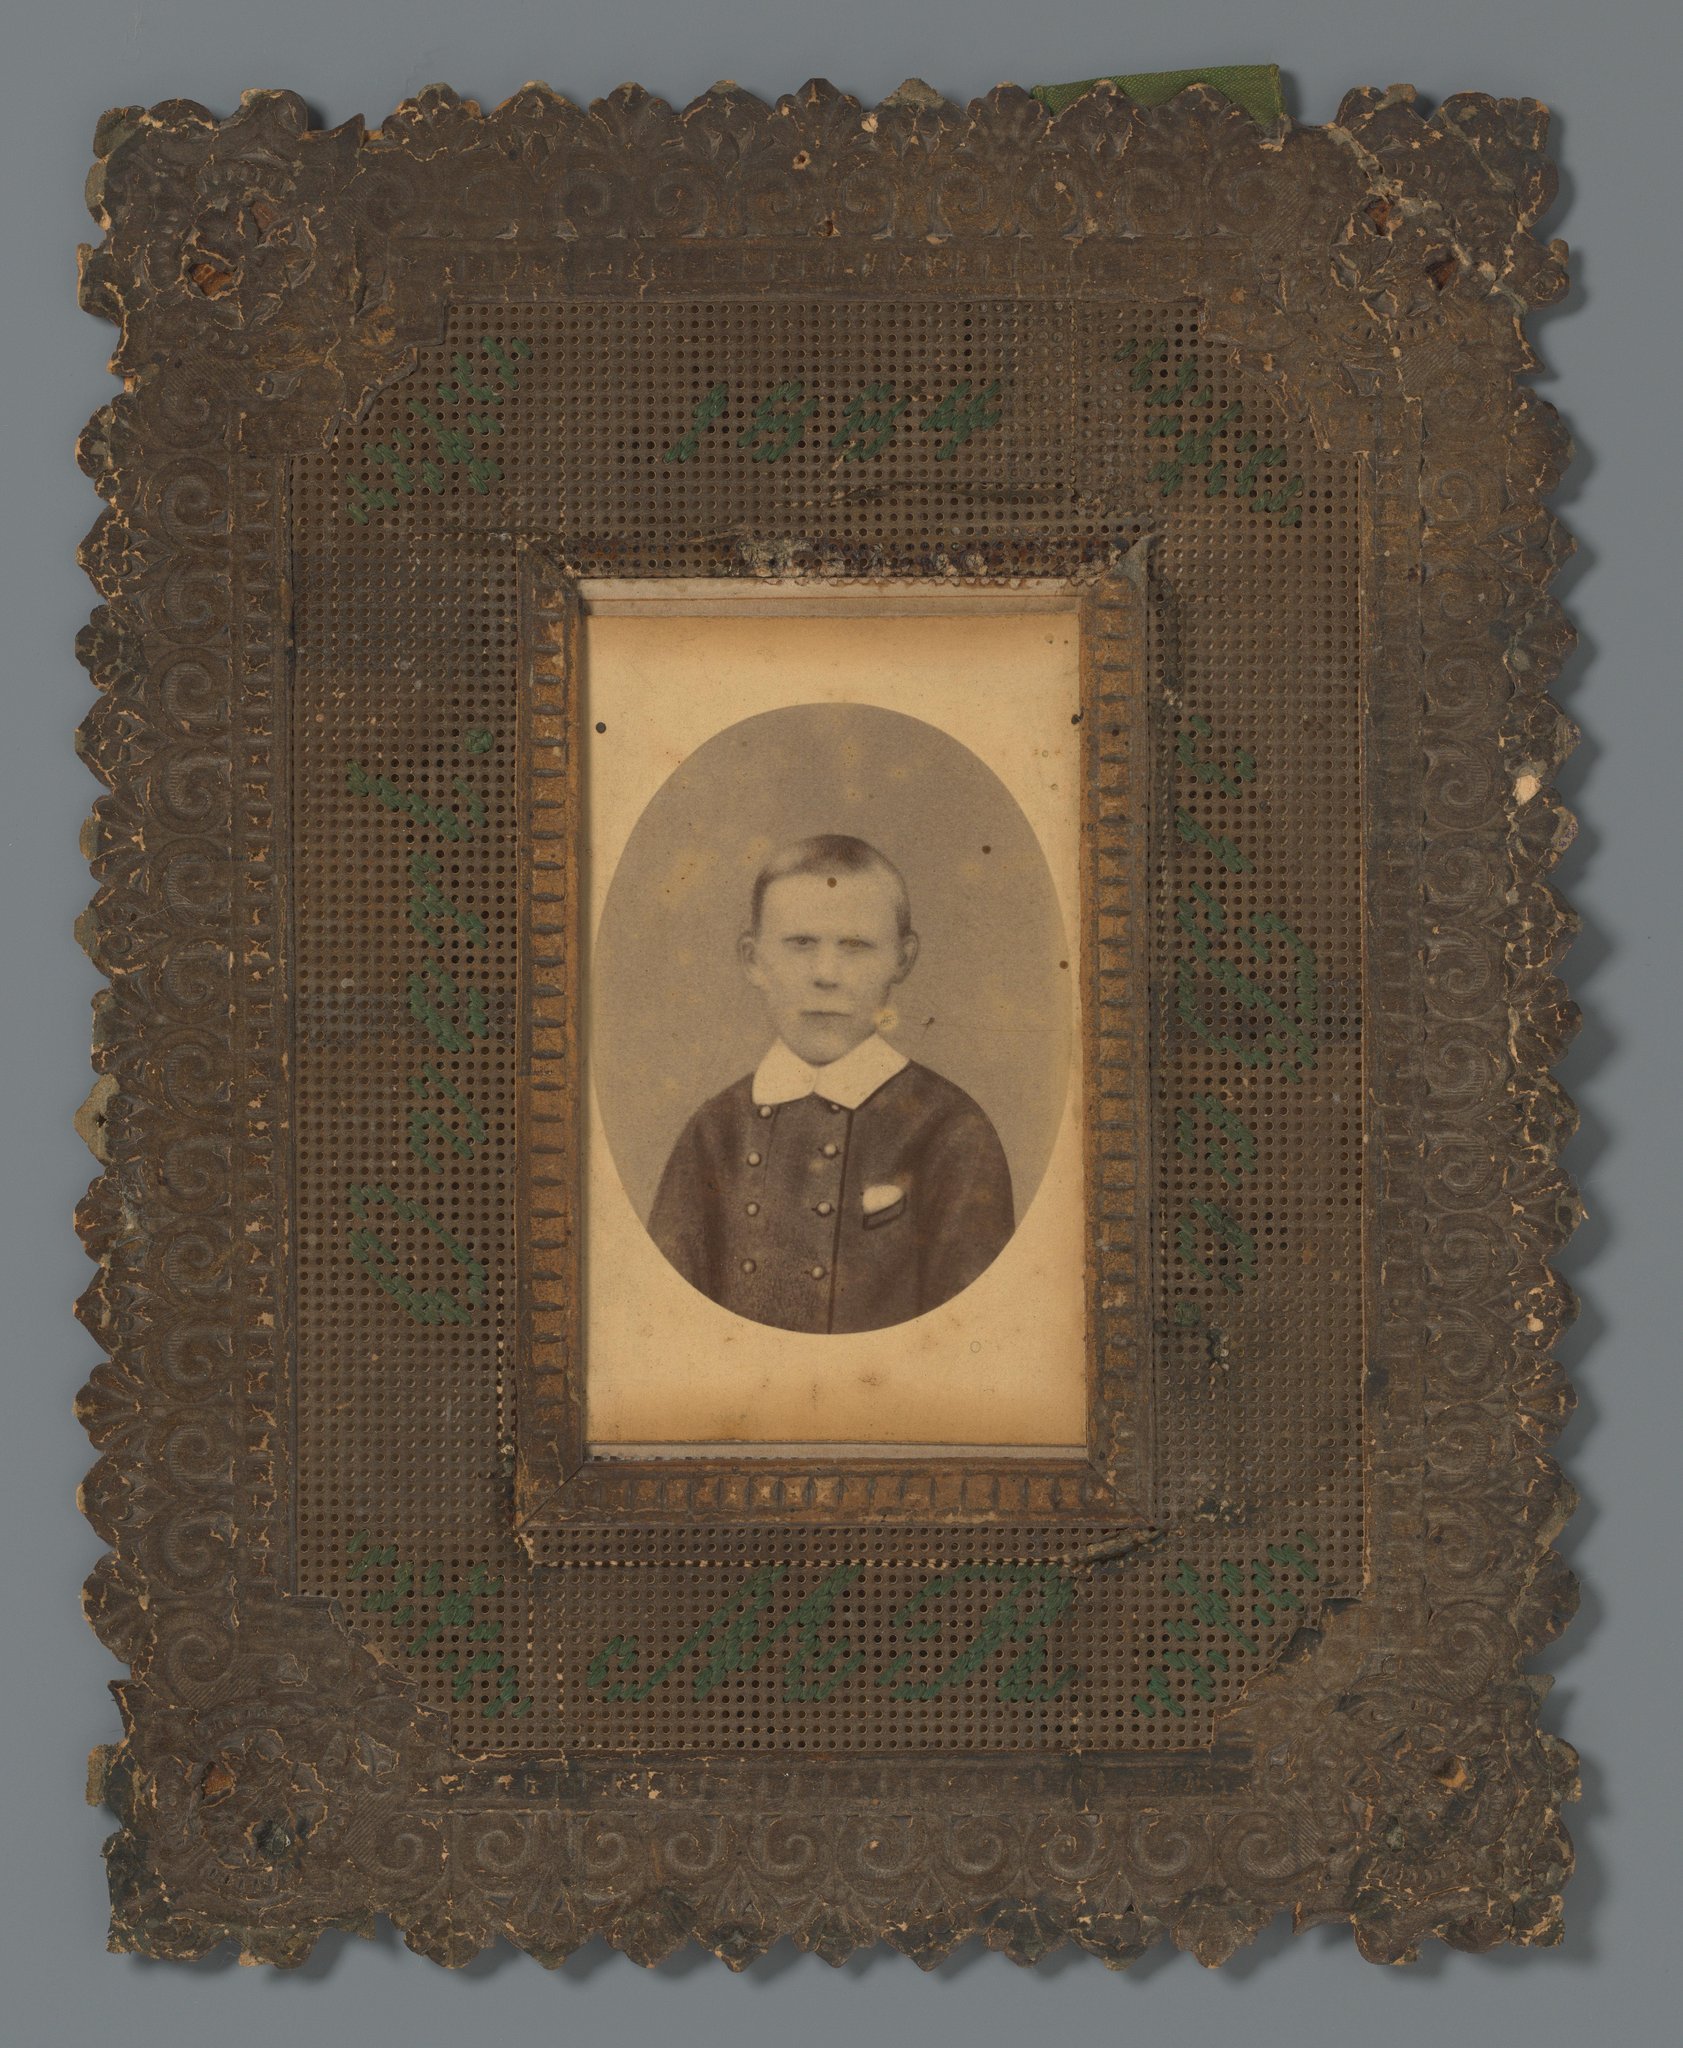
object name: photograph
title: Portret van een onbekende jongen, aangeduid als M.R., met tekst ter nagedachtenis aan zijn overlijden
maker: Anonymous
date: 1884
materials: cardboard, paper, textile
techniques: albumen print, embroidered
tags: boy (child between toddler and youth), anonymous historical person portrayed, netherlands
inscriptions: inscription: ‘1884/ 31 Dec./ M.R./ Overl.’